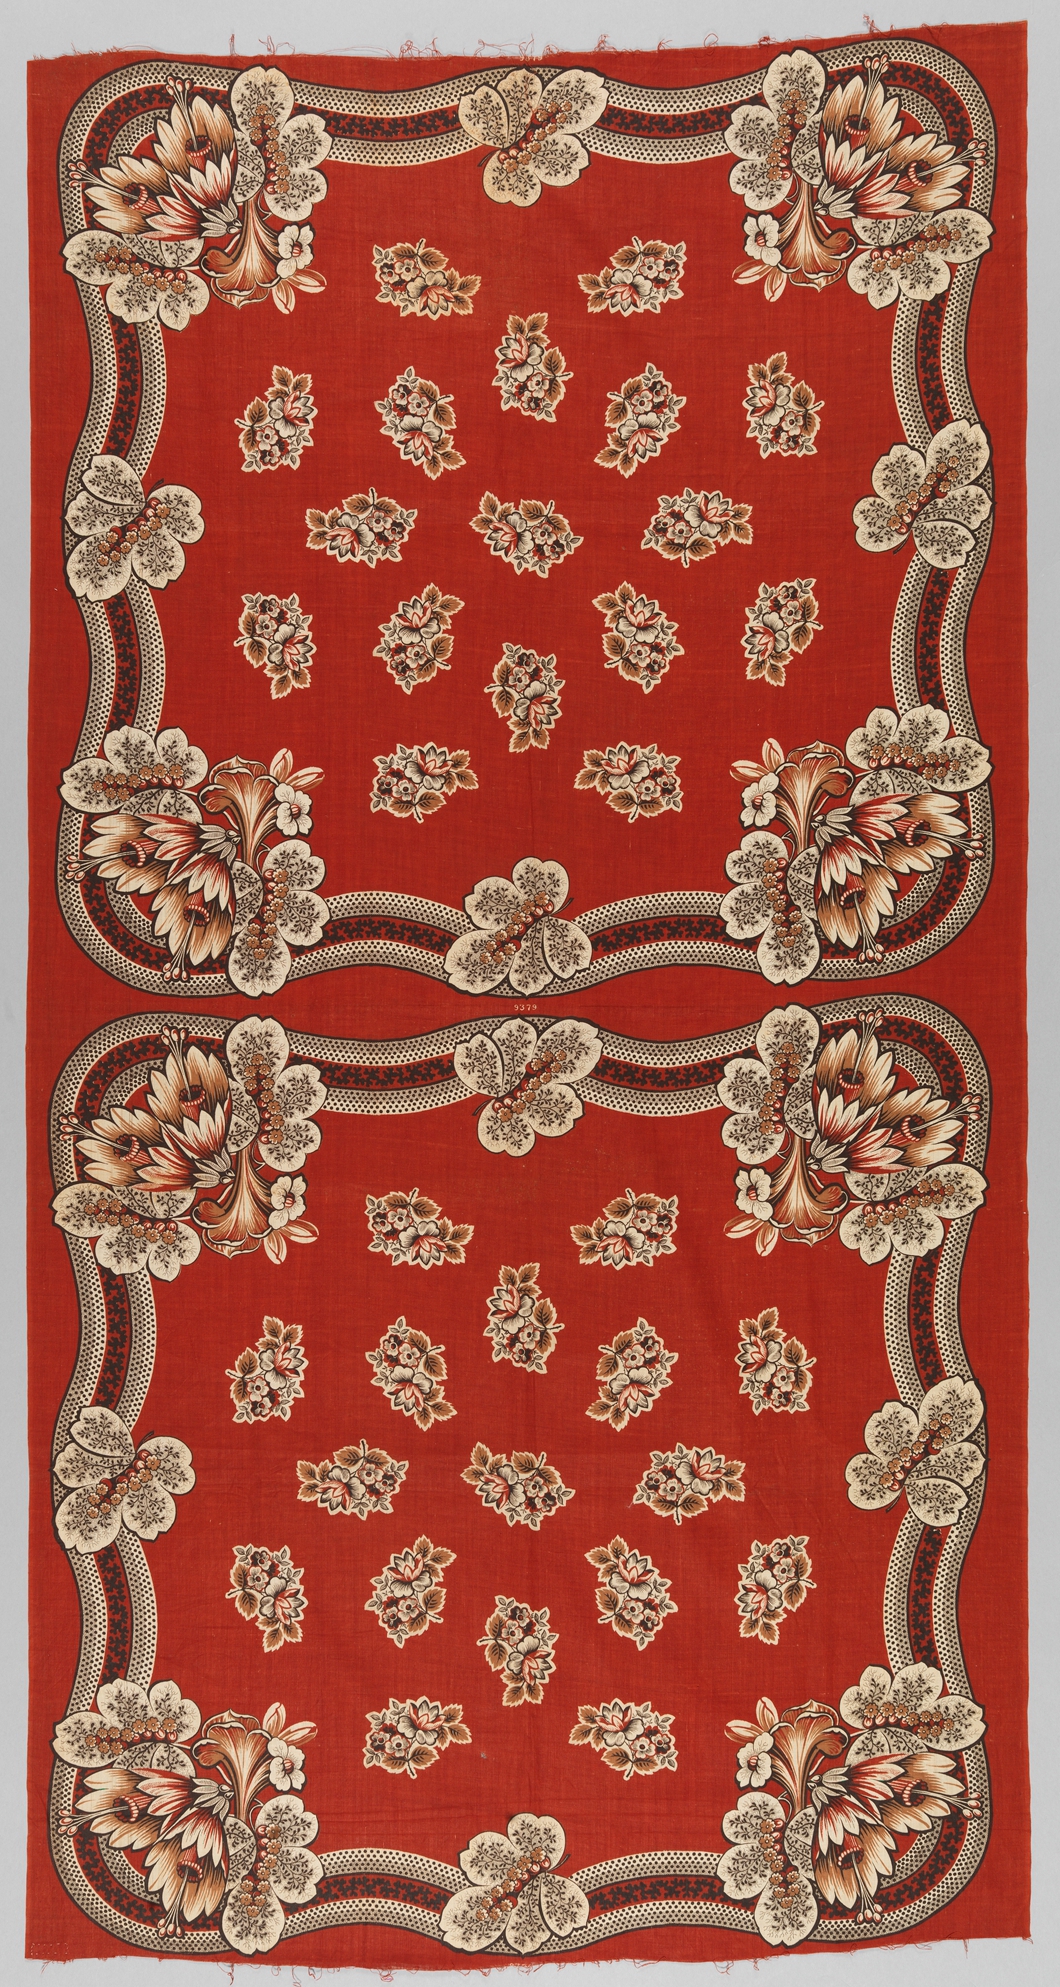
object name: bandana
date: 1801-1900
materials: cotton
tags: flowers